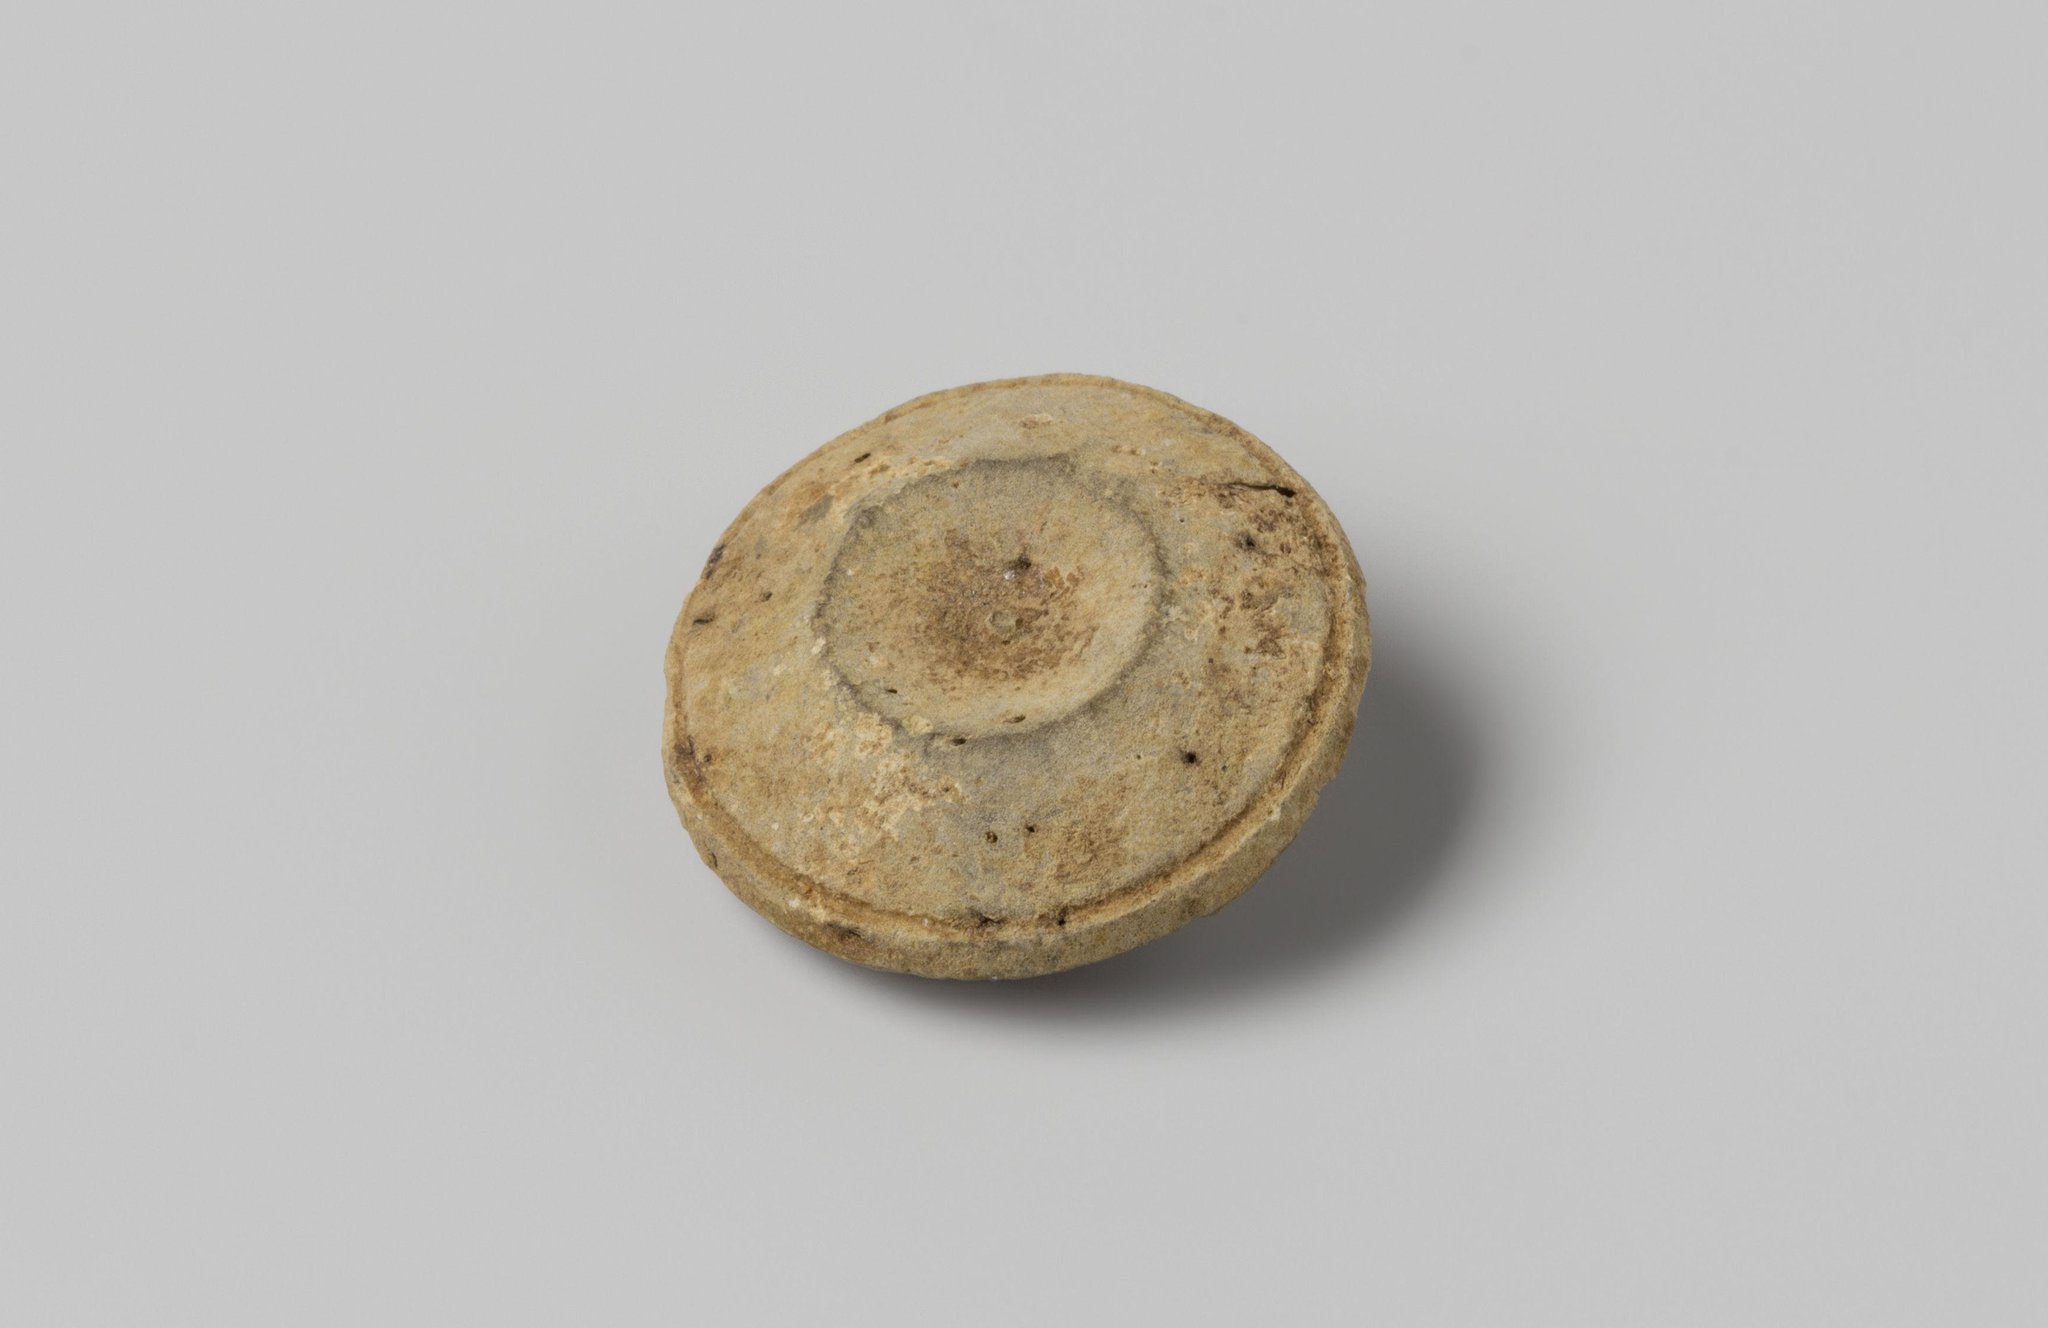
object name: button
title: Knoop uit het wrak van de Oost-Indiëvaarder Hollandia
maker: Anonymous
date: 1700-1743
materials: bone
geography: netherlands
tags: verenigde oostindische compagnie, hollandia (schip), annet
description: Knoop. (1) concentric moulding (2.1d, 0.5t)